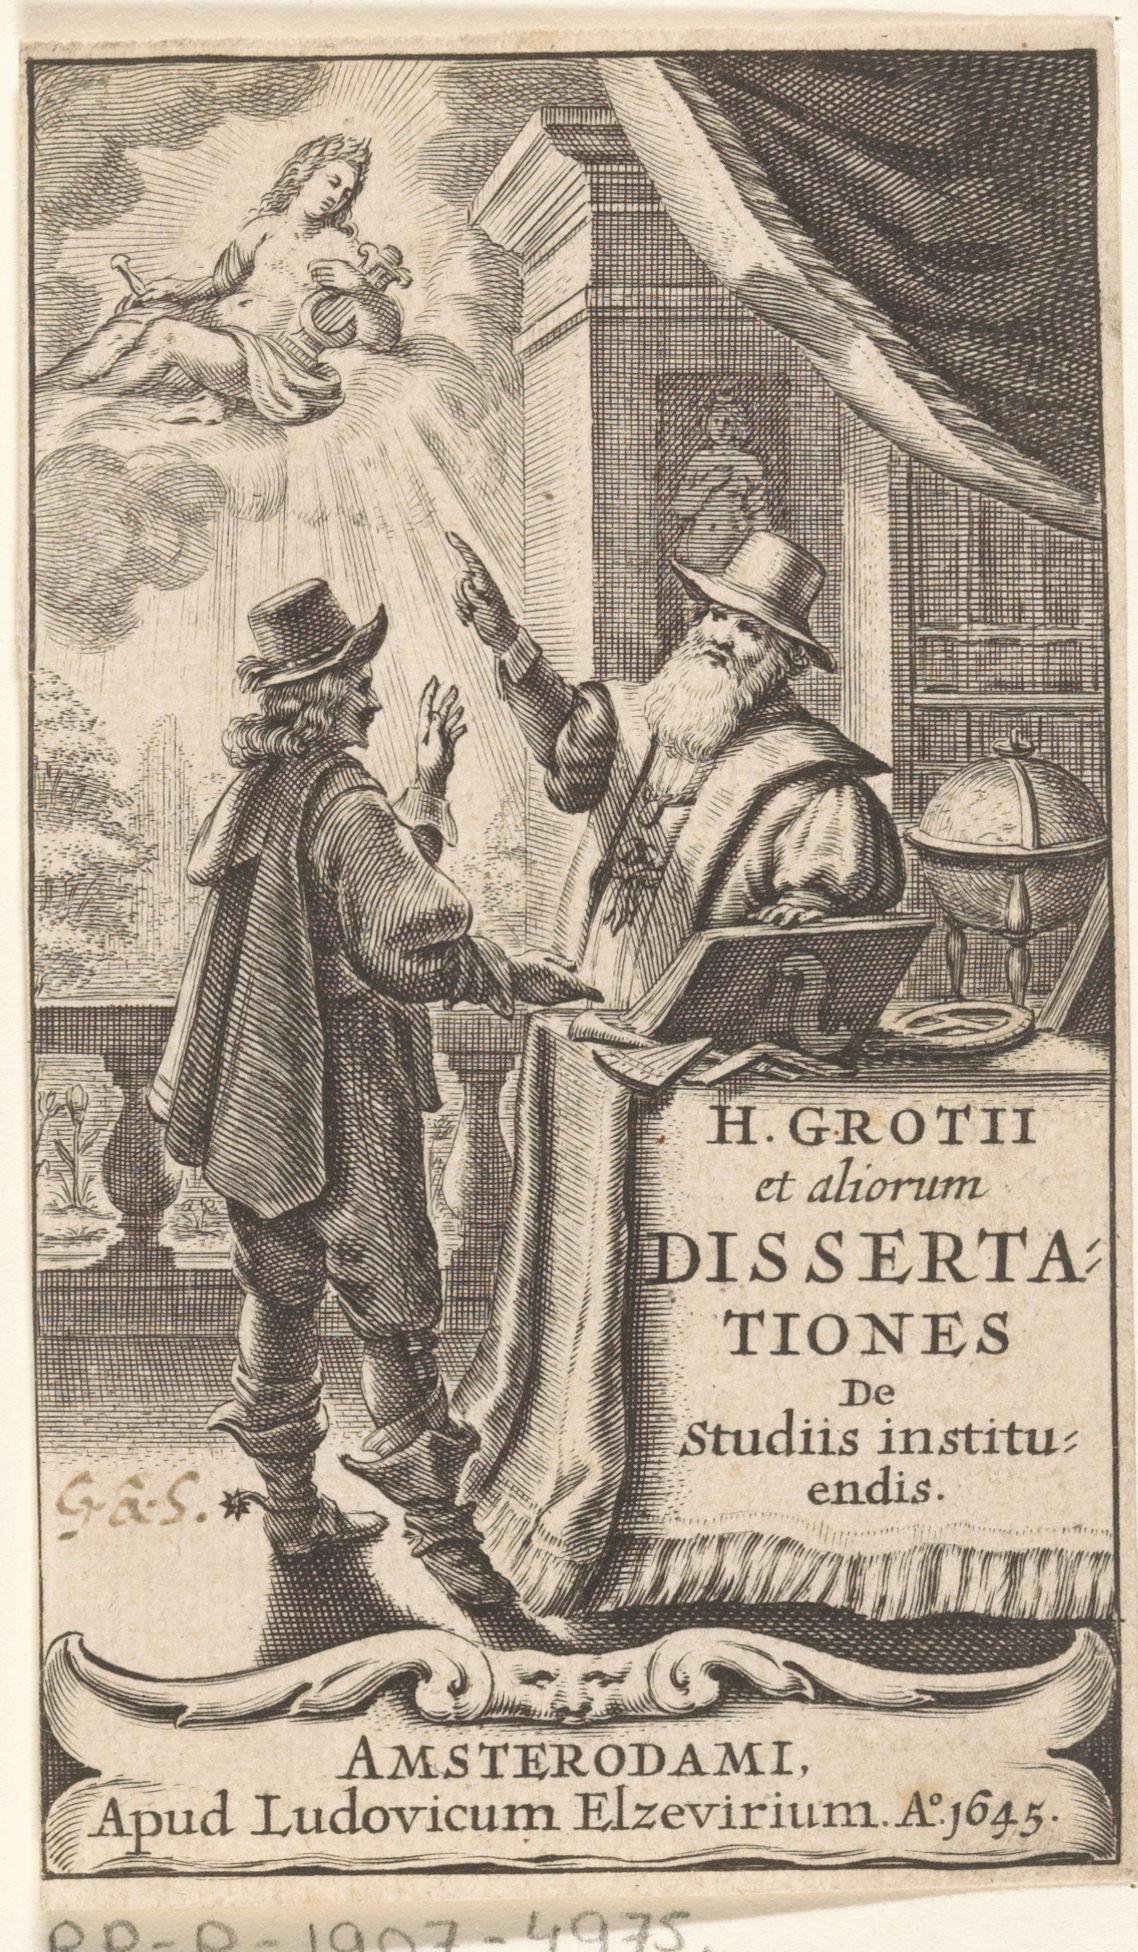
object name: print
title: Twee mannen en Apollo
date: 1645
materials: paper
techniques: engraving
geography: amsterdam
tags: standing figure, (story of) apollo (phoebus)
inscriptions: inscription: ‘G.â.S.’, collector's mark: Lugt 2228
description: Een oude man met baard en hoed en een man met hoed staan voor een tafel met open boek. Zij wijzen naar de lucht waar de god Apollo met lier verschijnt.